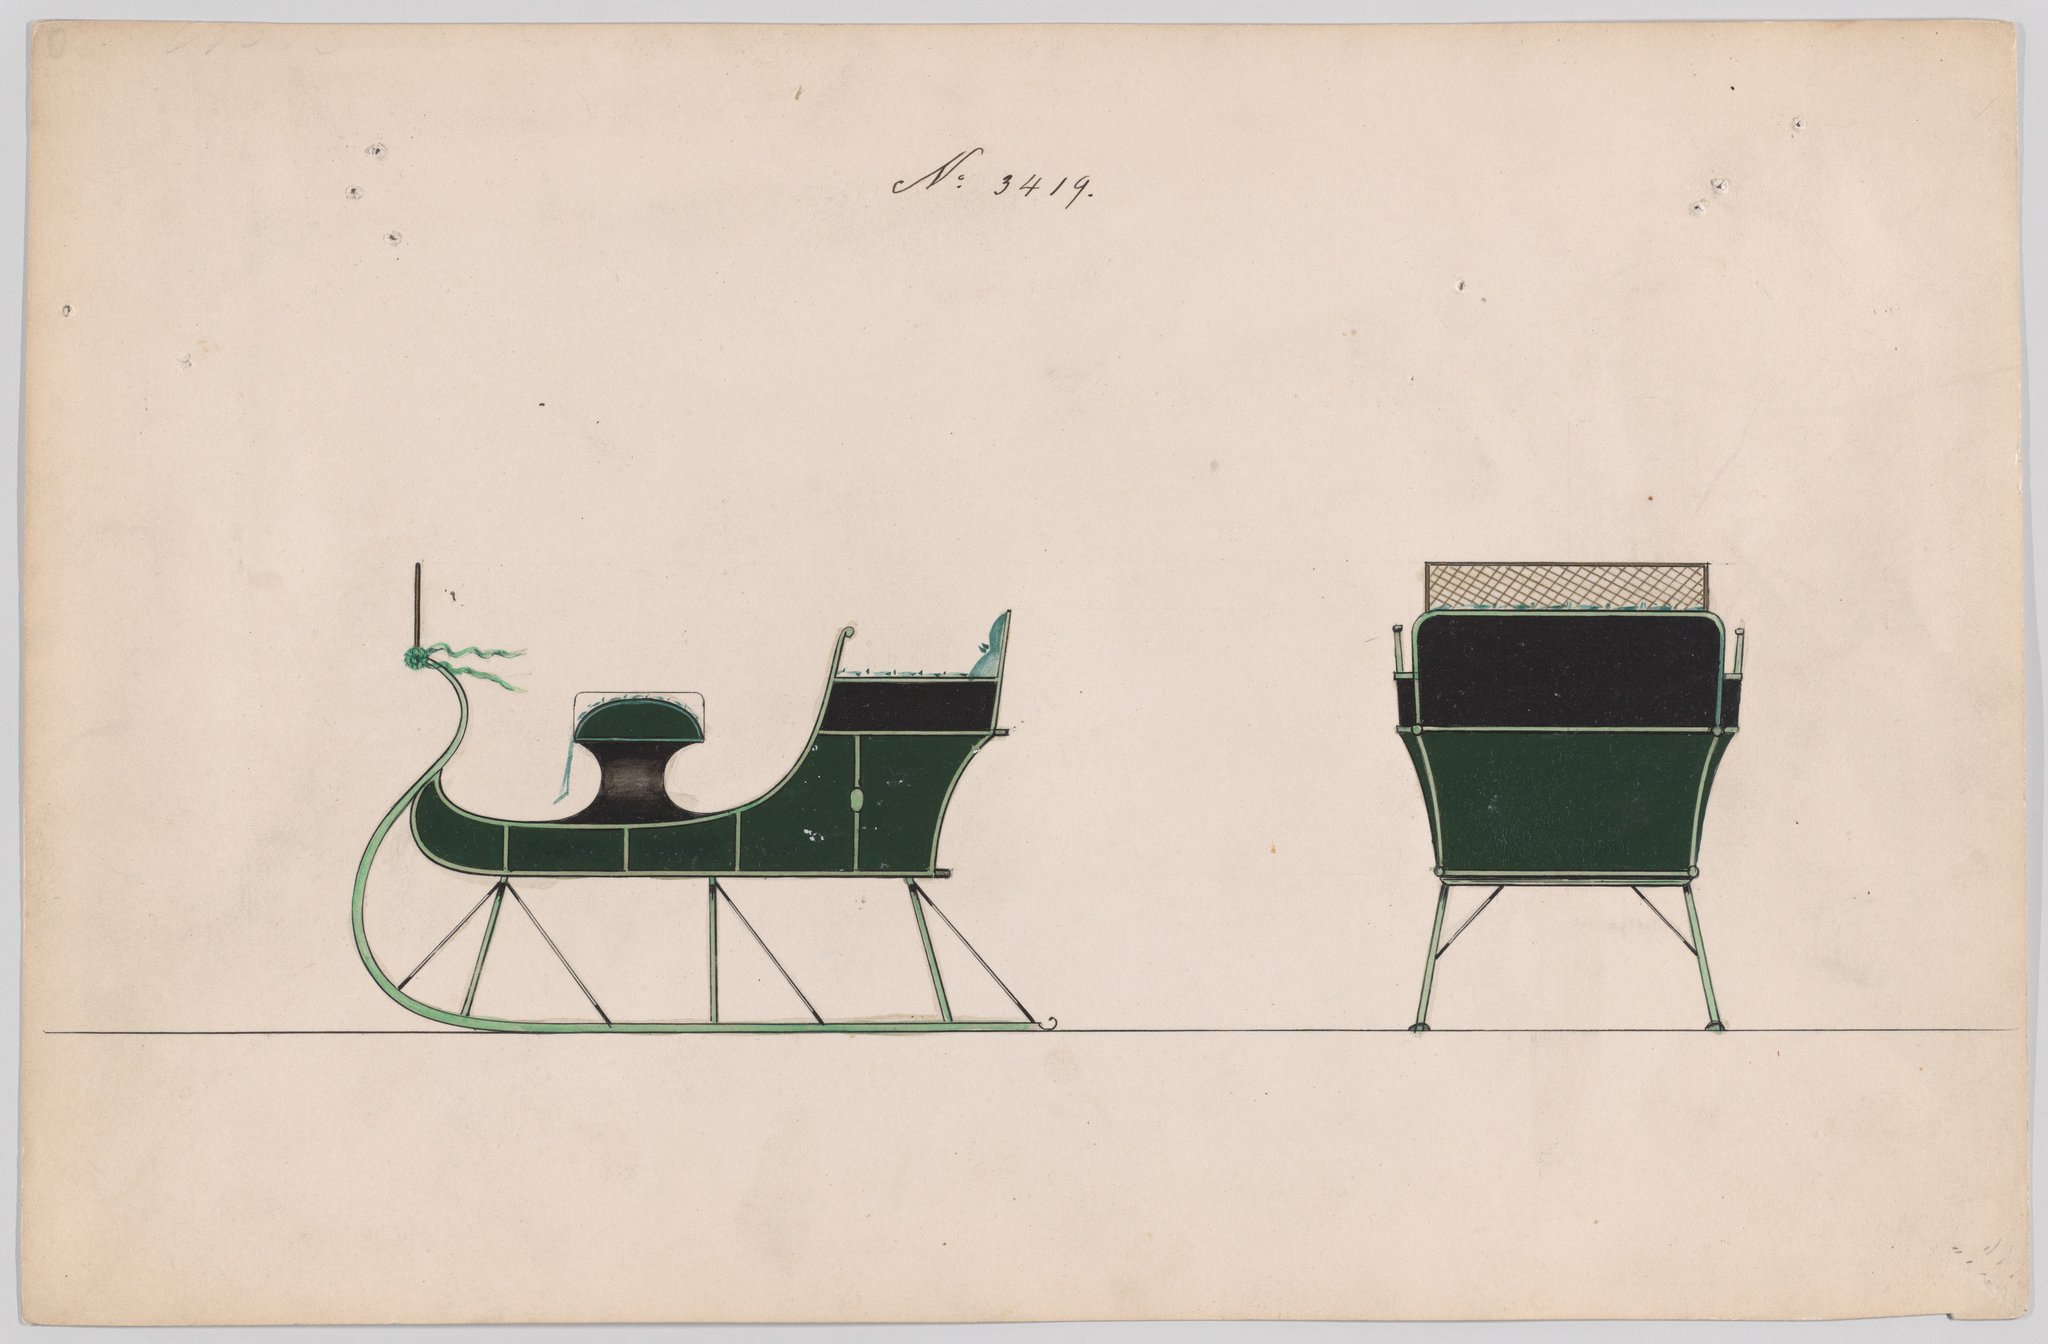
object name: drawing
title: Design for 4 Seat Sleigh, no. 3419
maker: brewster & co.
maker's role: manufacturer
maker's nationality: american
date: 1878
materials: gouache, gum arabic, ink, watercolor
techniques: pen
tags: sleighs